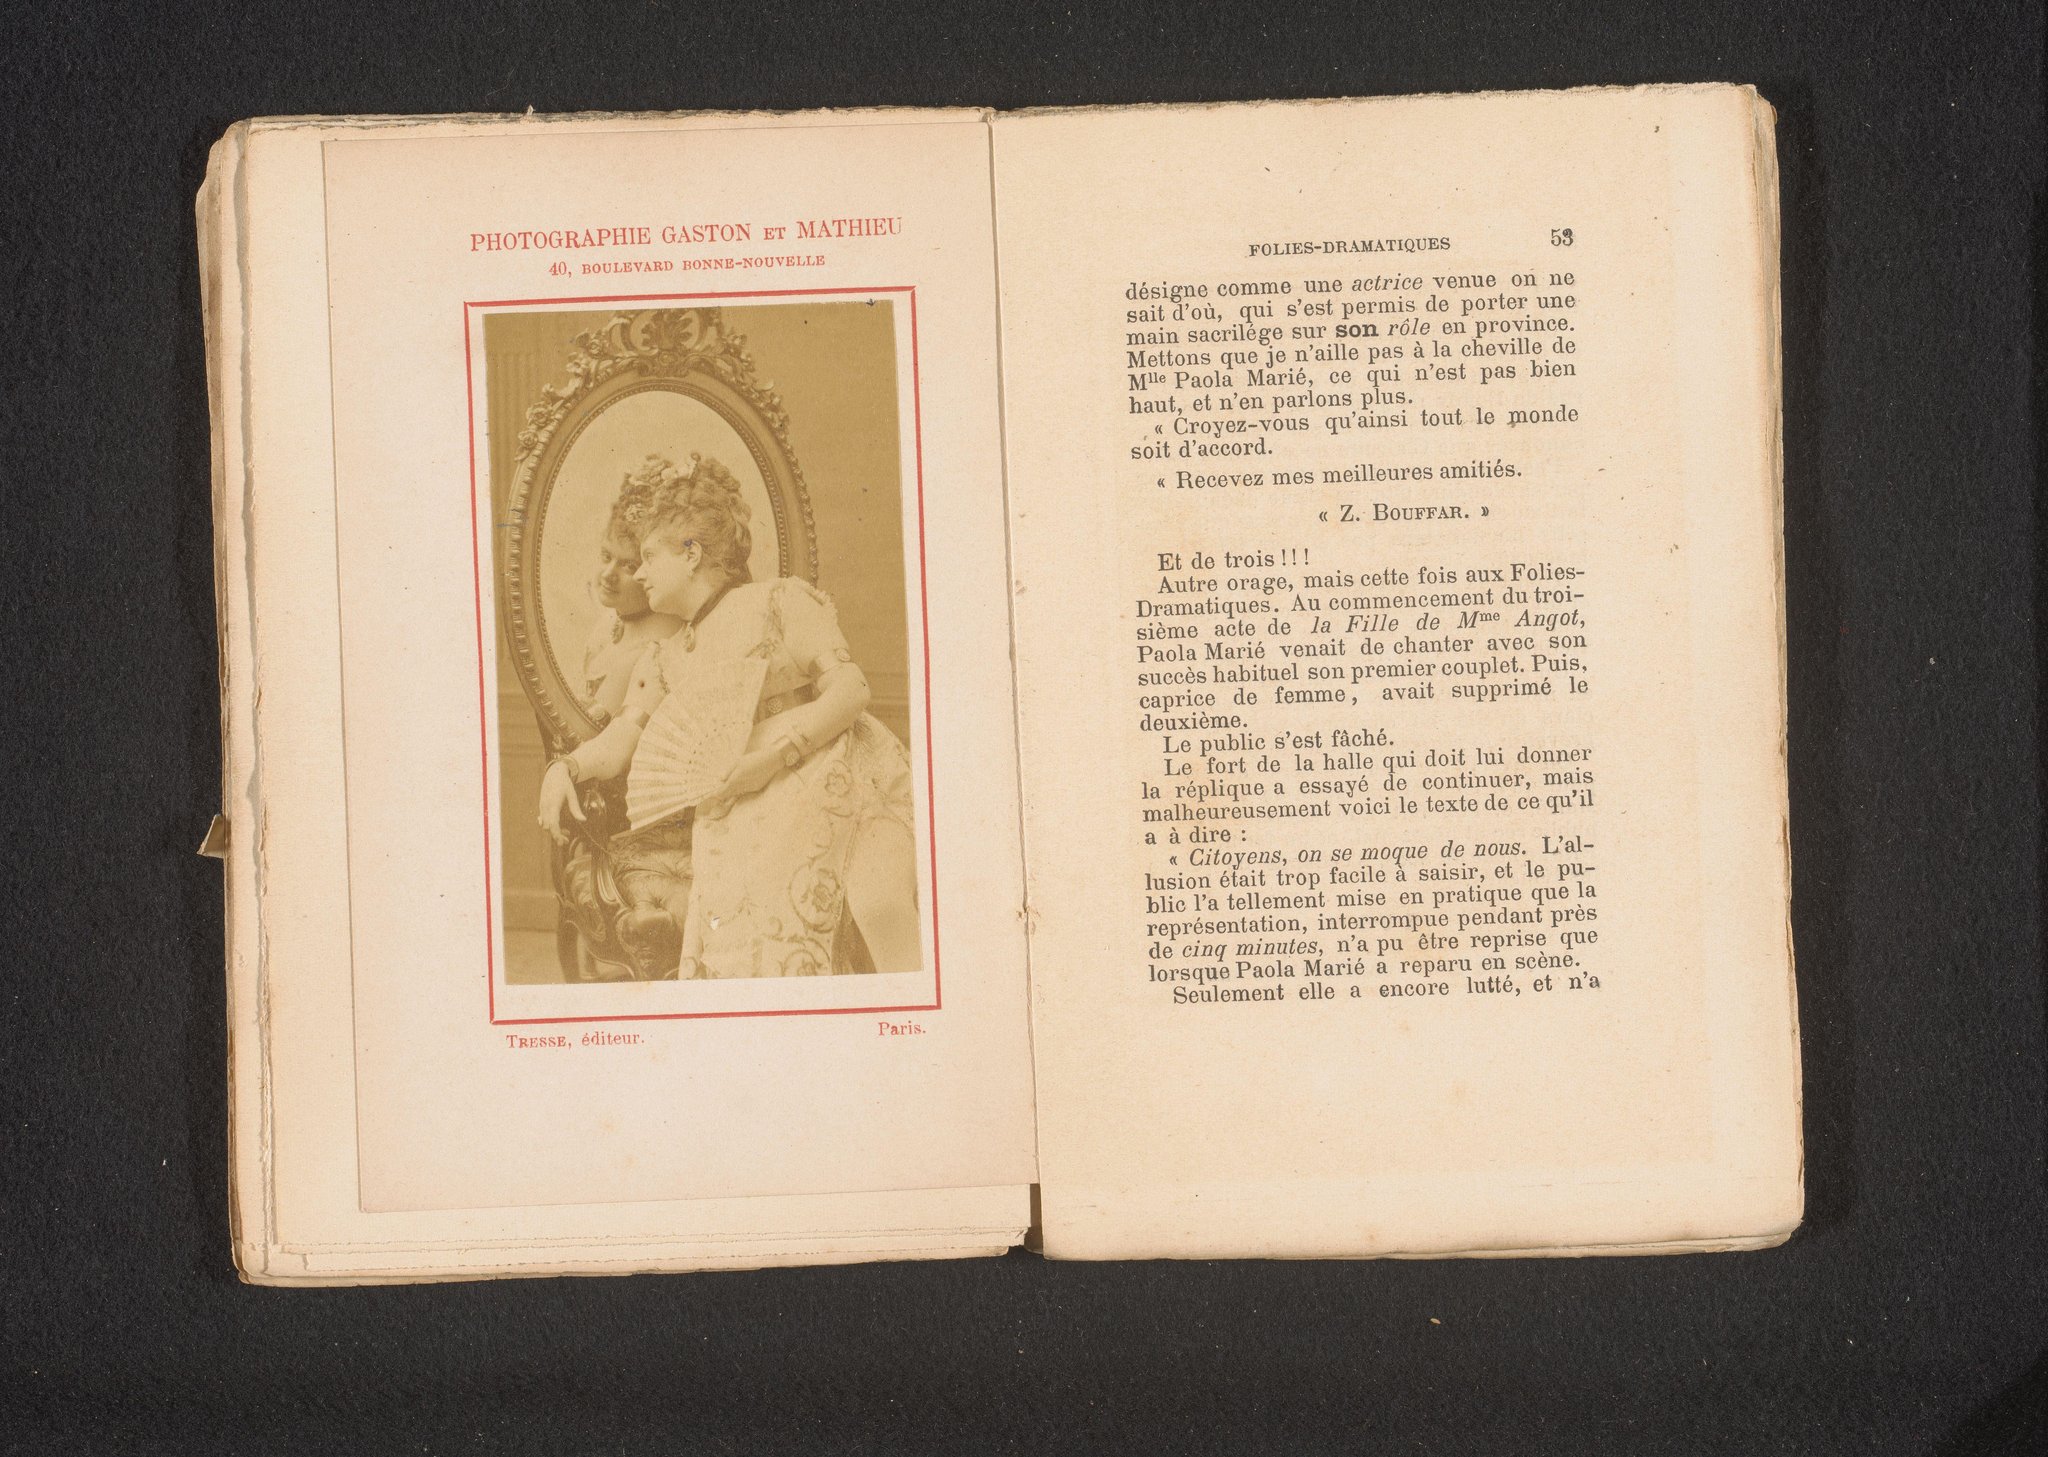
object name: page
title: Portret van een Franse actrice voor een spiegel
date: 1863-1873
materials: photographic support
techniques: albumen print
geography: paris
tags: portrait of actor, actress